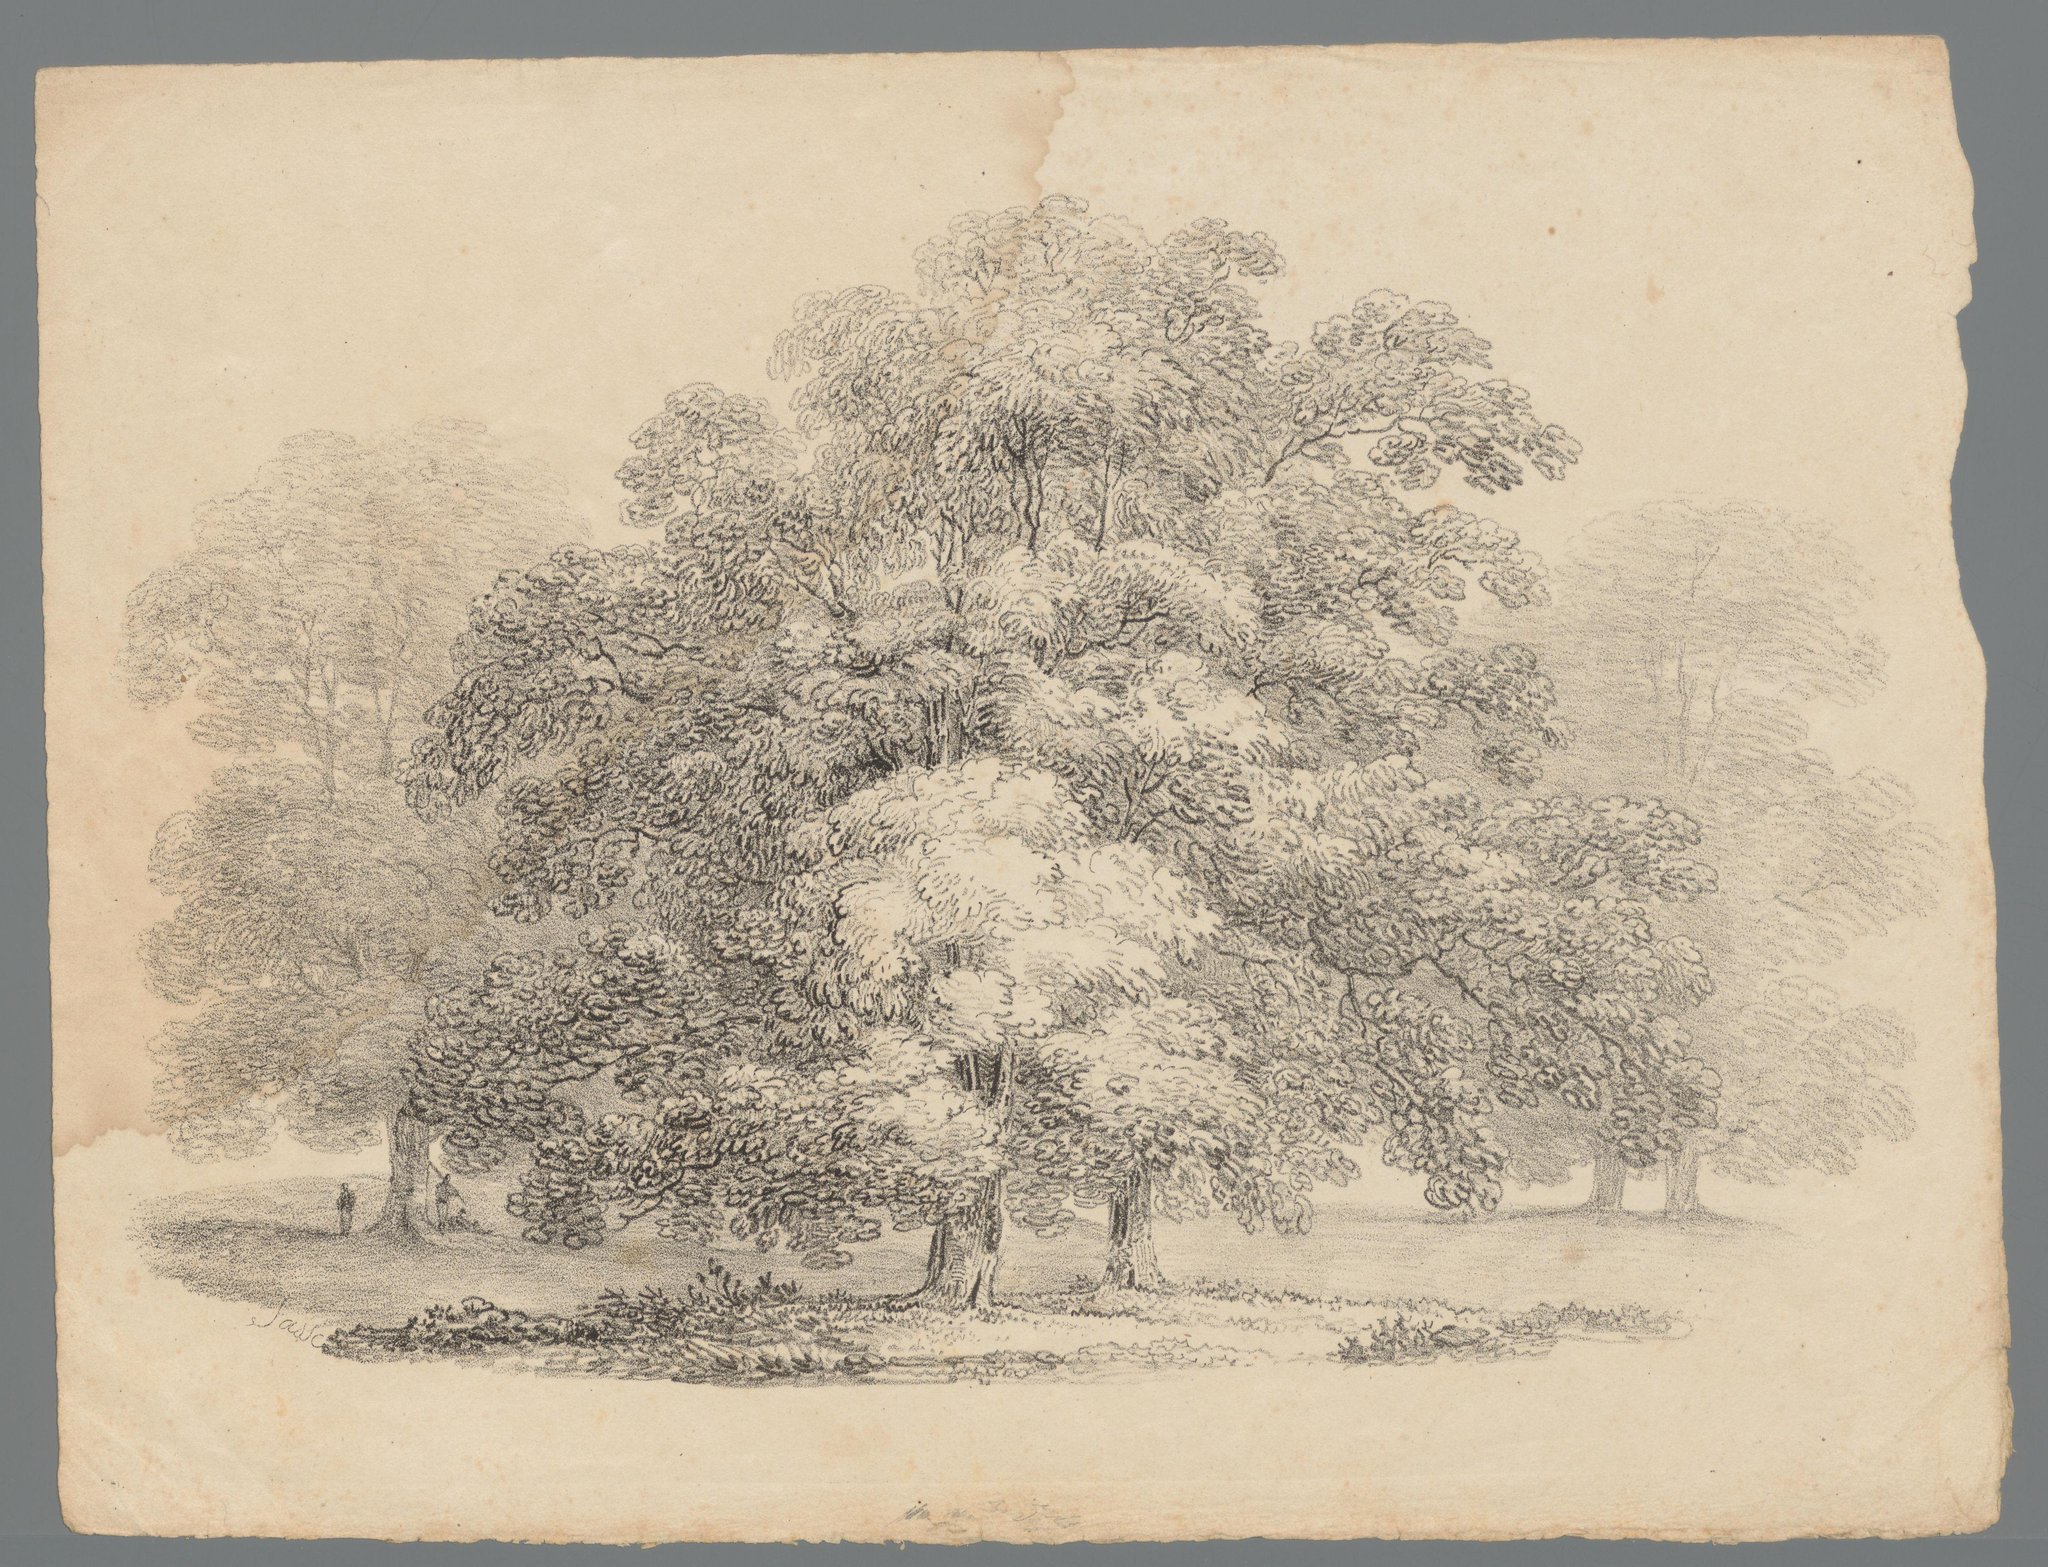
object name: print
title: Eikenbomen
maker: richard sasse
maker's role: print maker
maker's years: 1774-1849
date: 1800-1849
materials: paper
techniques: lithograph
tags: trees: oak, landscapes in the temperate zone (+ landscape with figures, staffage)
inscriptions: collector's mark: Lugt 2228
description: Prent behoort tot de serie 'L'art de dessiner le paysage d'apres nature'. Deze serie is in tien delen met elk zes lithografieën uitgegeven.